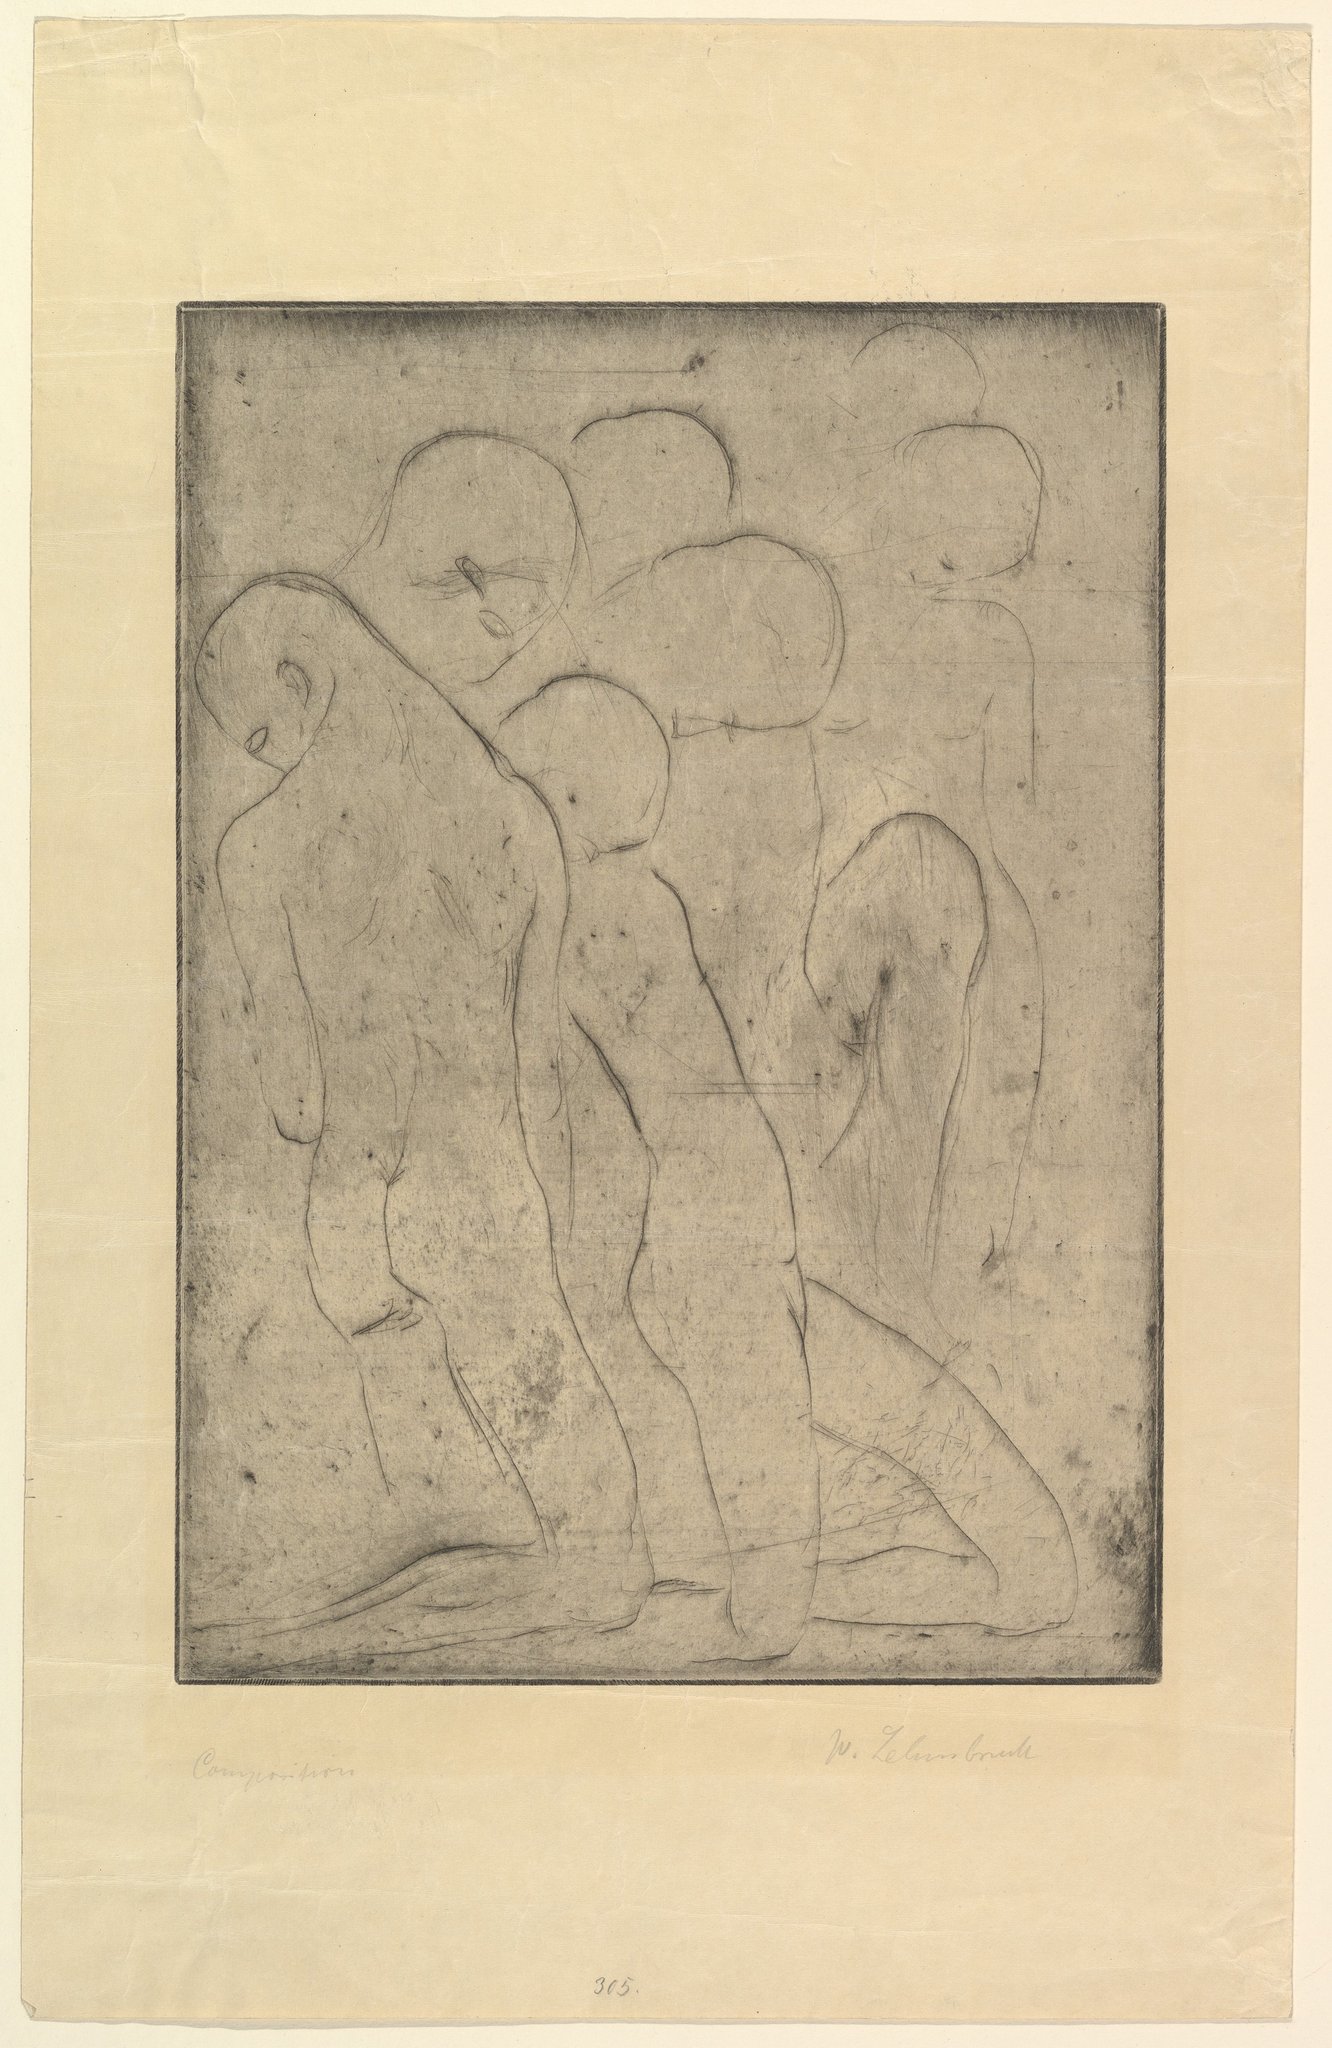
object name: print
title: Composition (Große Komposition)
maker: wilhelm lehmbruck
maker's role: artist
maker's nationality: german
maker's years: 1881-1919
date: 1913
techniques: drypoint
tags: human figures